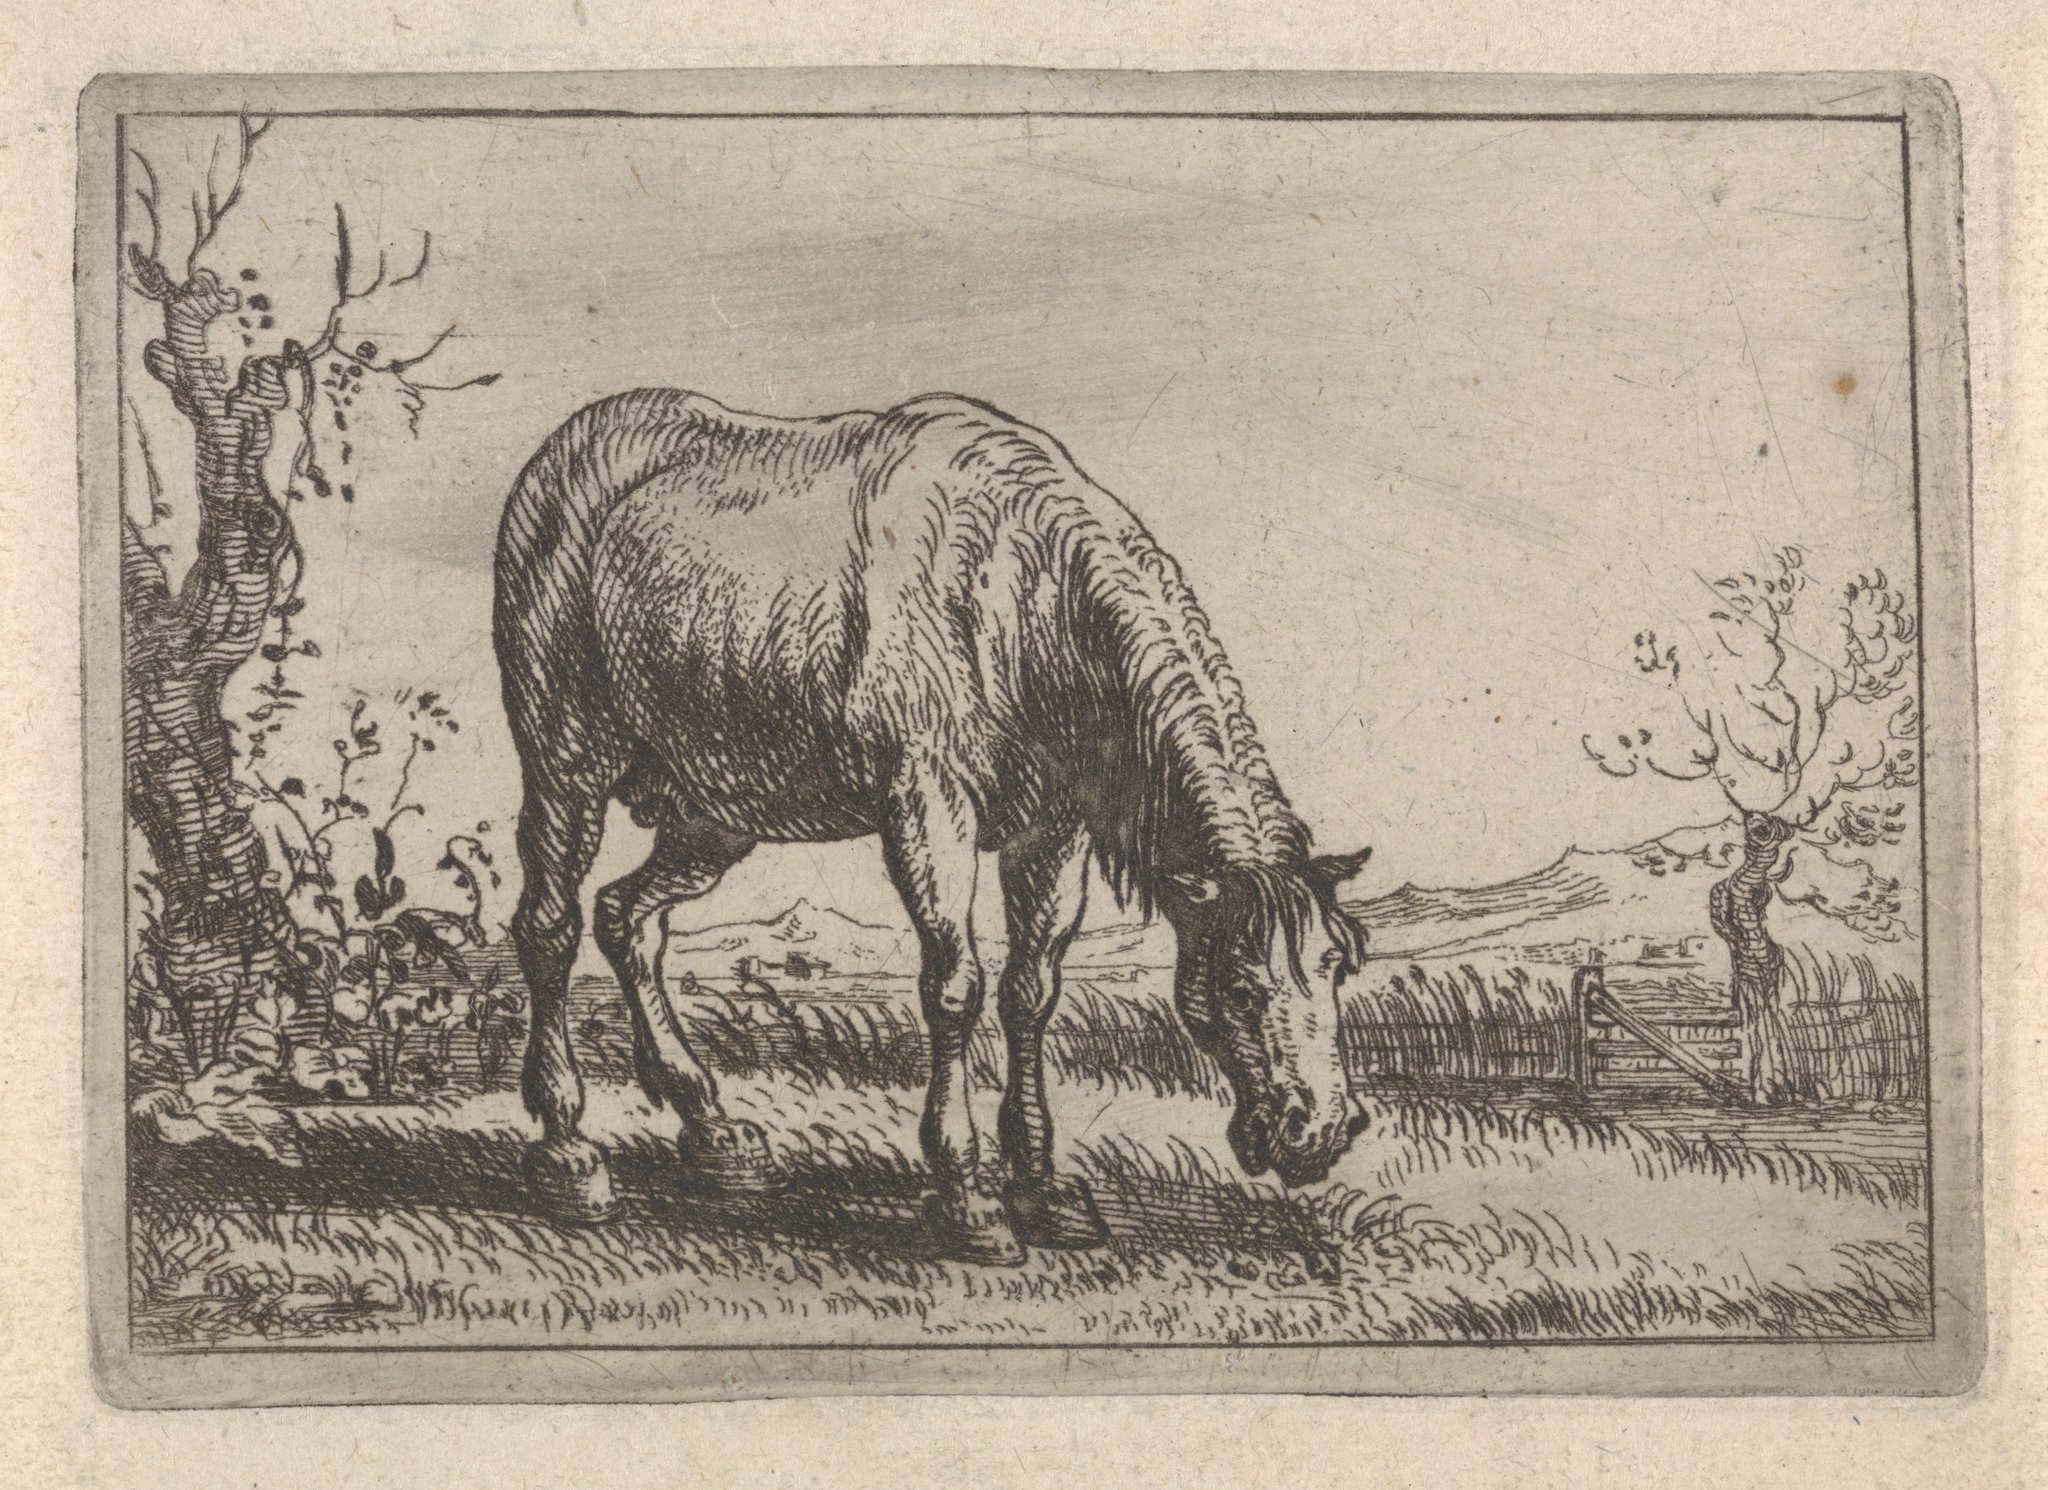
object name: print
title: Diverse dieren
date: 1654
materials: paper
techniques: etching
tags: meadow, pasture, horse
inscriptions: collector's mark: Lugt 2228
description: In een weide in een landschap staat een paard, terzijde gezien, te grazen. Deze prent maakt deel uit van een tiendelige serie over diverse dieren.